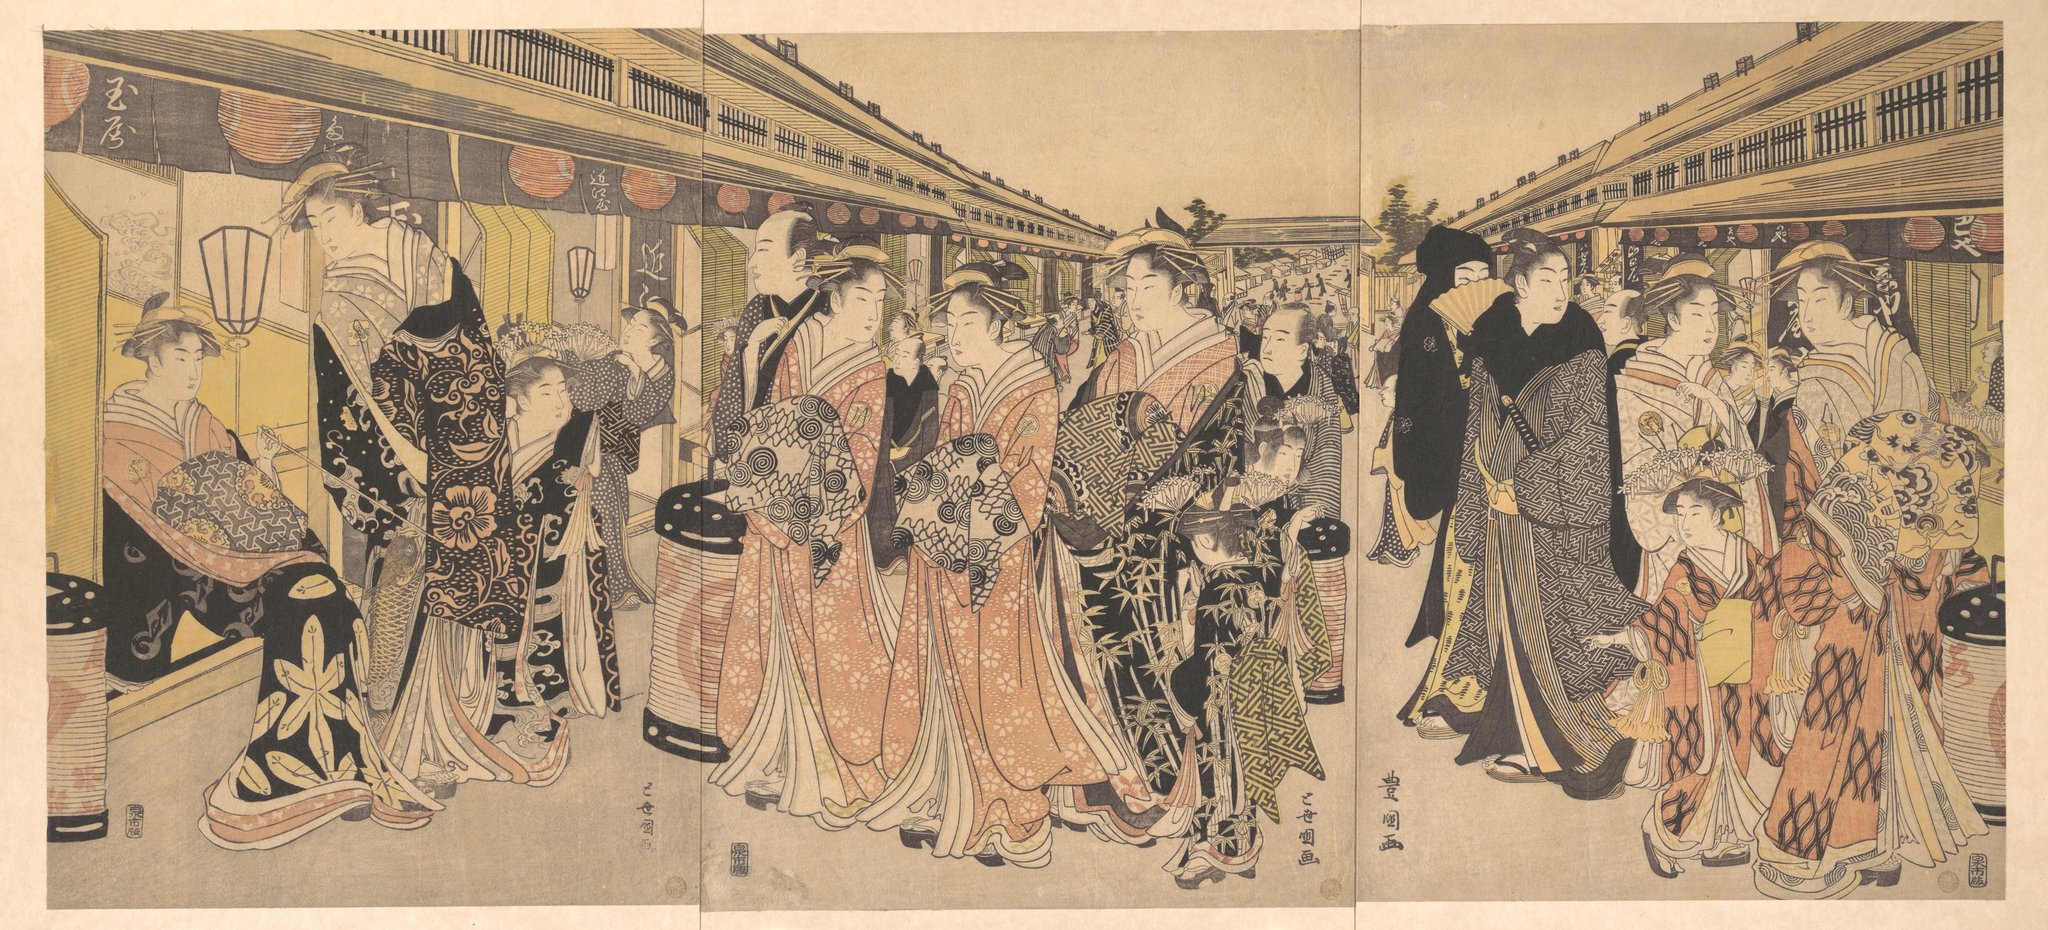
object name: print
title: Courtesans Promenading on the Nakanochō in Yoshiwara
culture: japanese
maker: utagawa toyokuni i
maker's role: artist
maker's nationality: japanese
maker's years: 1769-1825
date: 1795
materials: ink, paper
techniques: woodblock print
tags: men,women